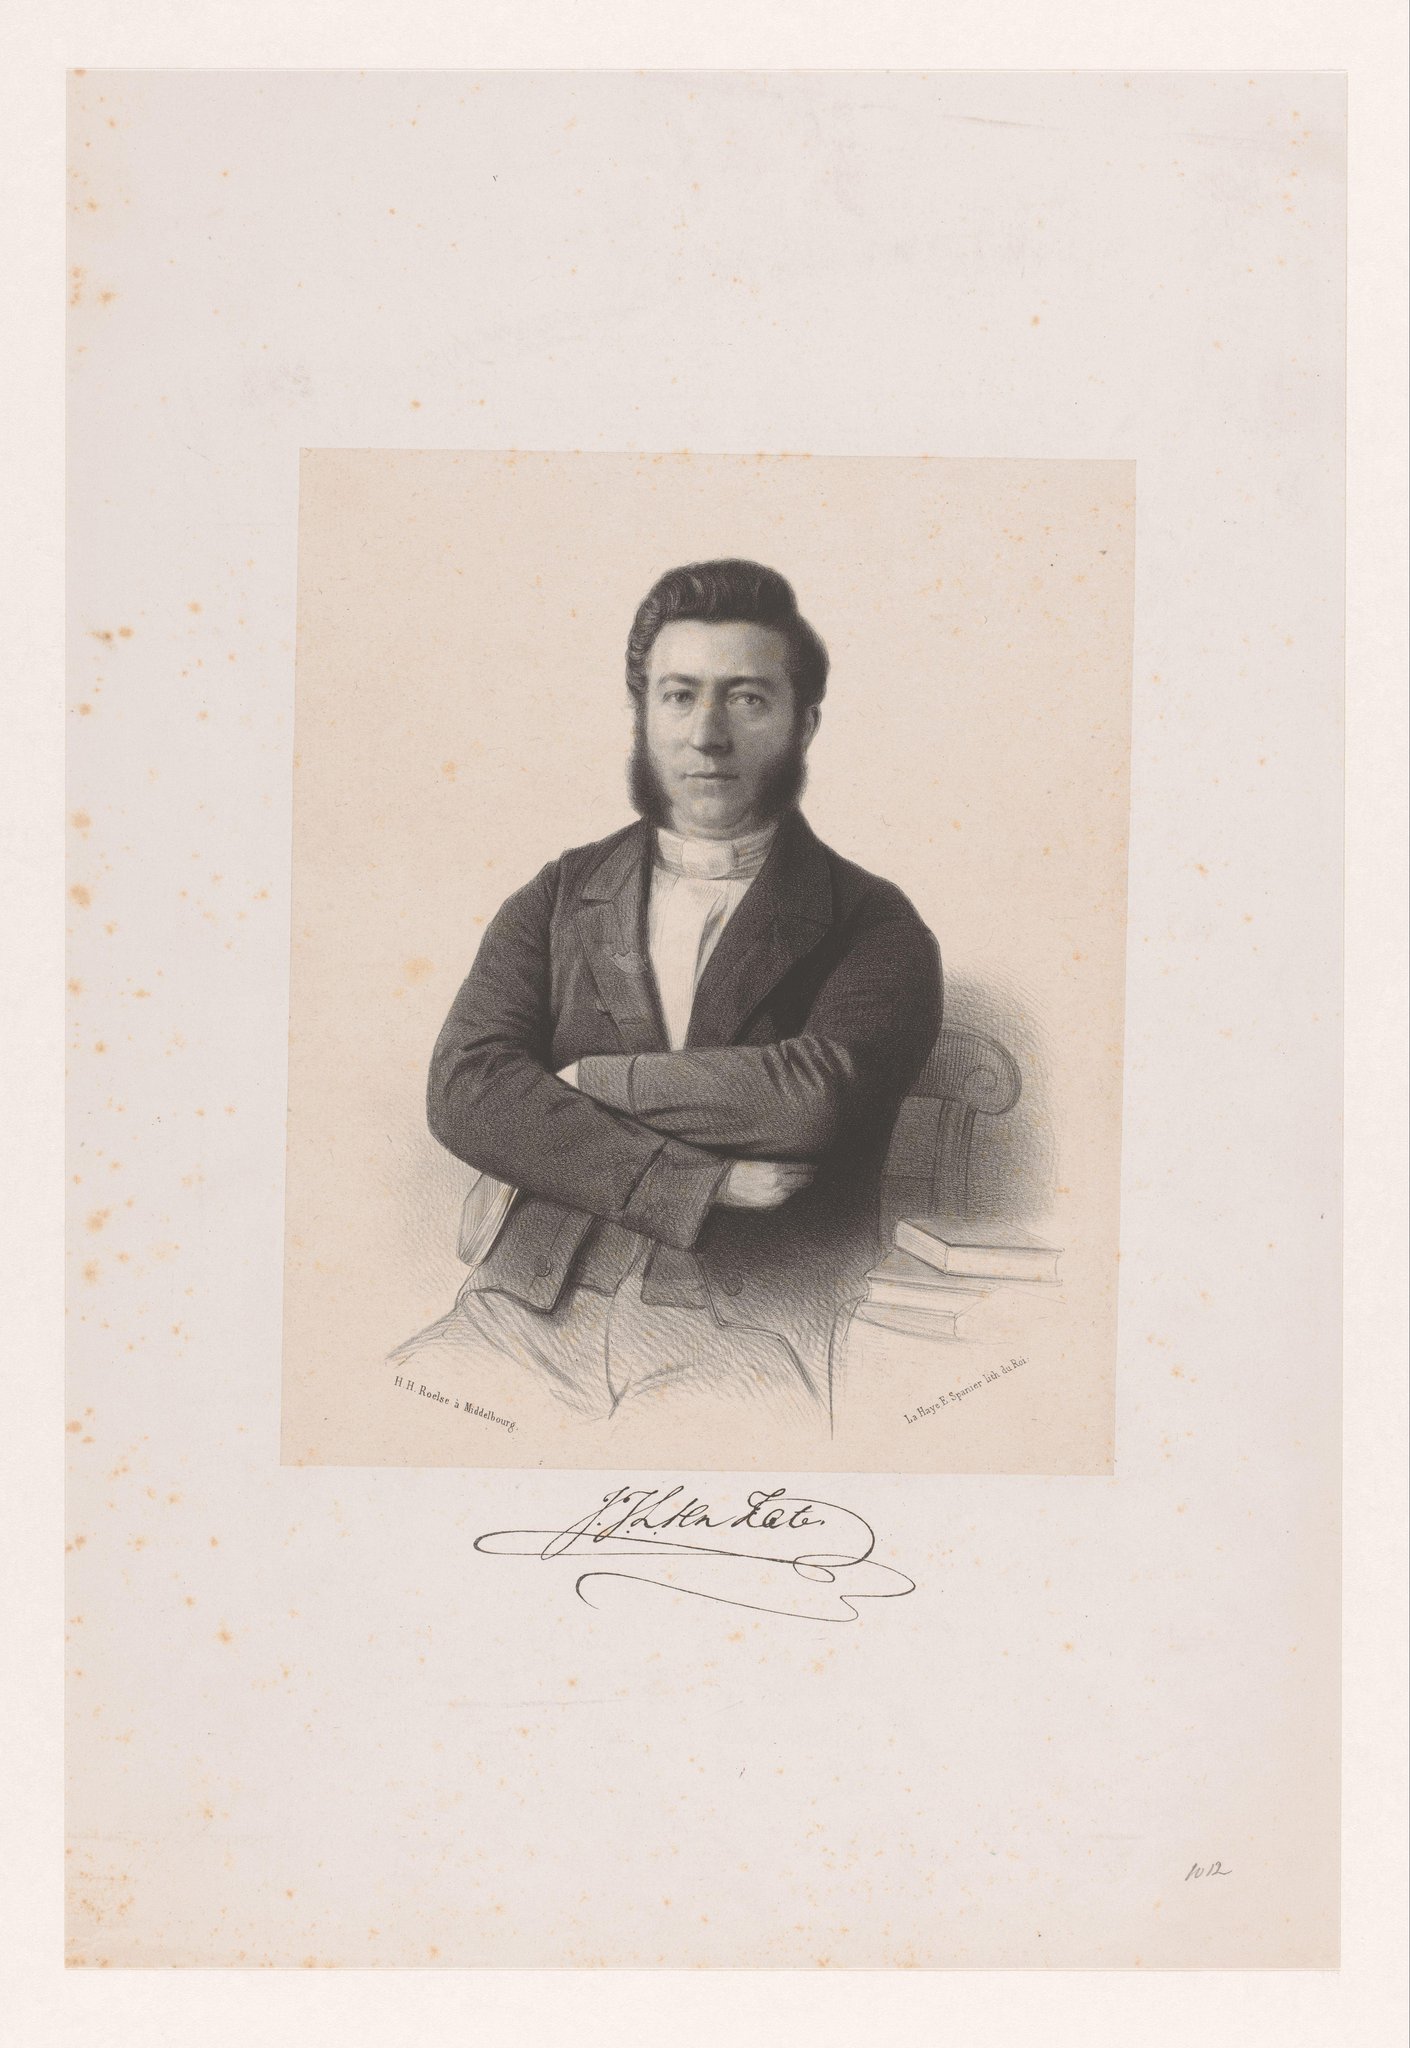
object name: print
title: Portret van Jan Jacob Lodewijk ten Kate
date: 1841-1863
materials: paper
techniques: lithograph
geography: the hague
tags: the hague, amsterdam, jan jakob lodewijk ten kate, historical persons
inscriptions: collector's mark: Lugt 2228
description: Onder het portret de signatuur van de geportretteerde.